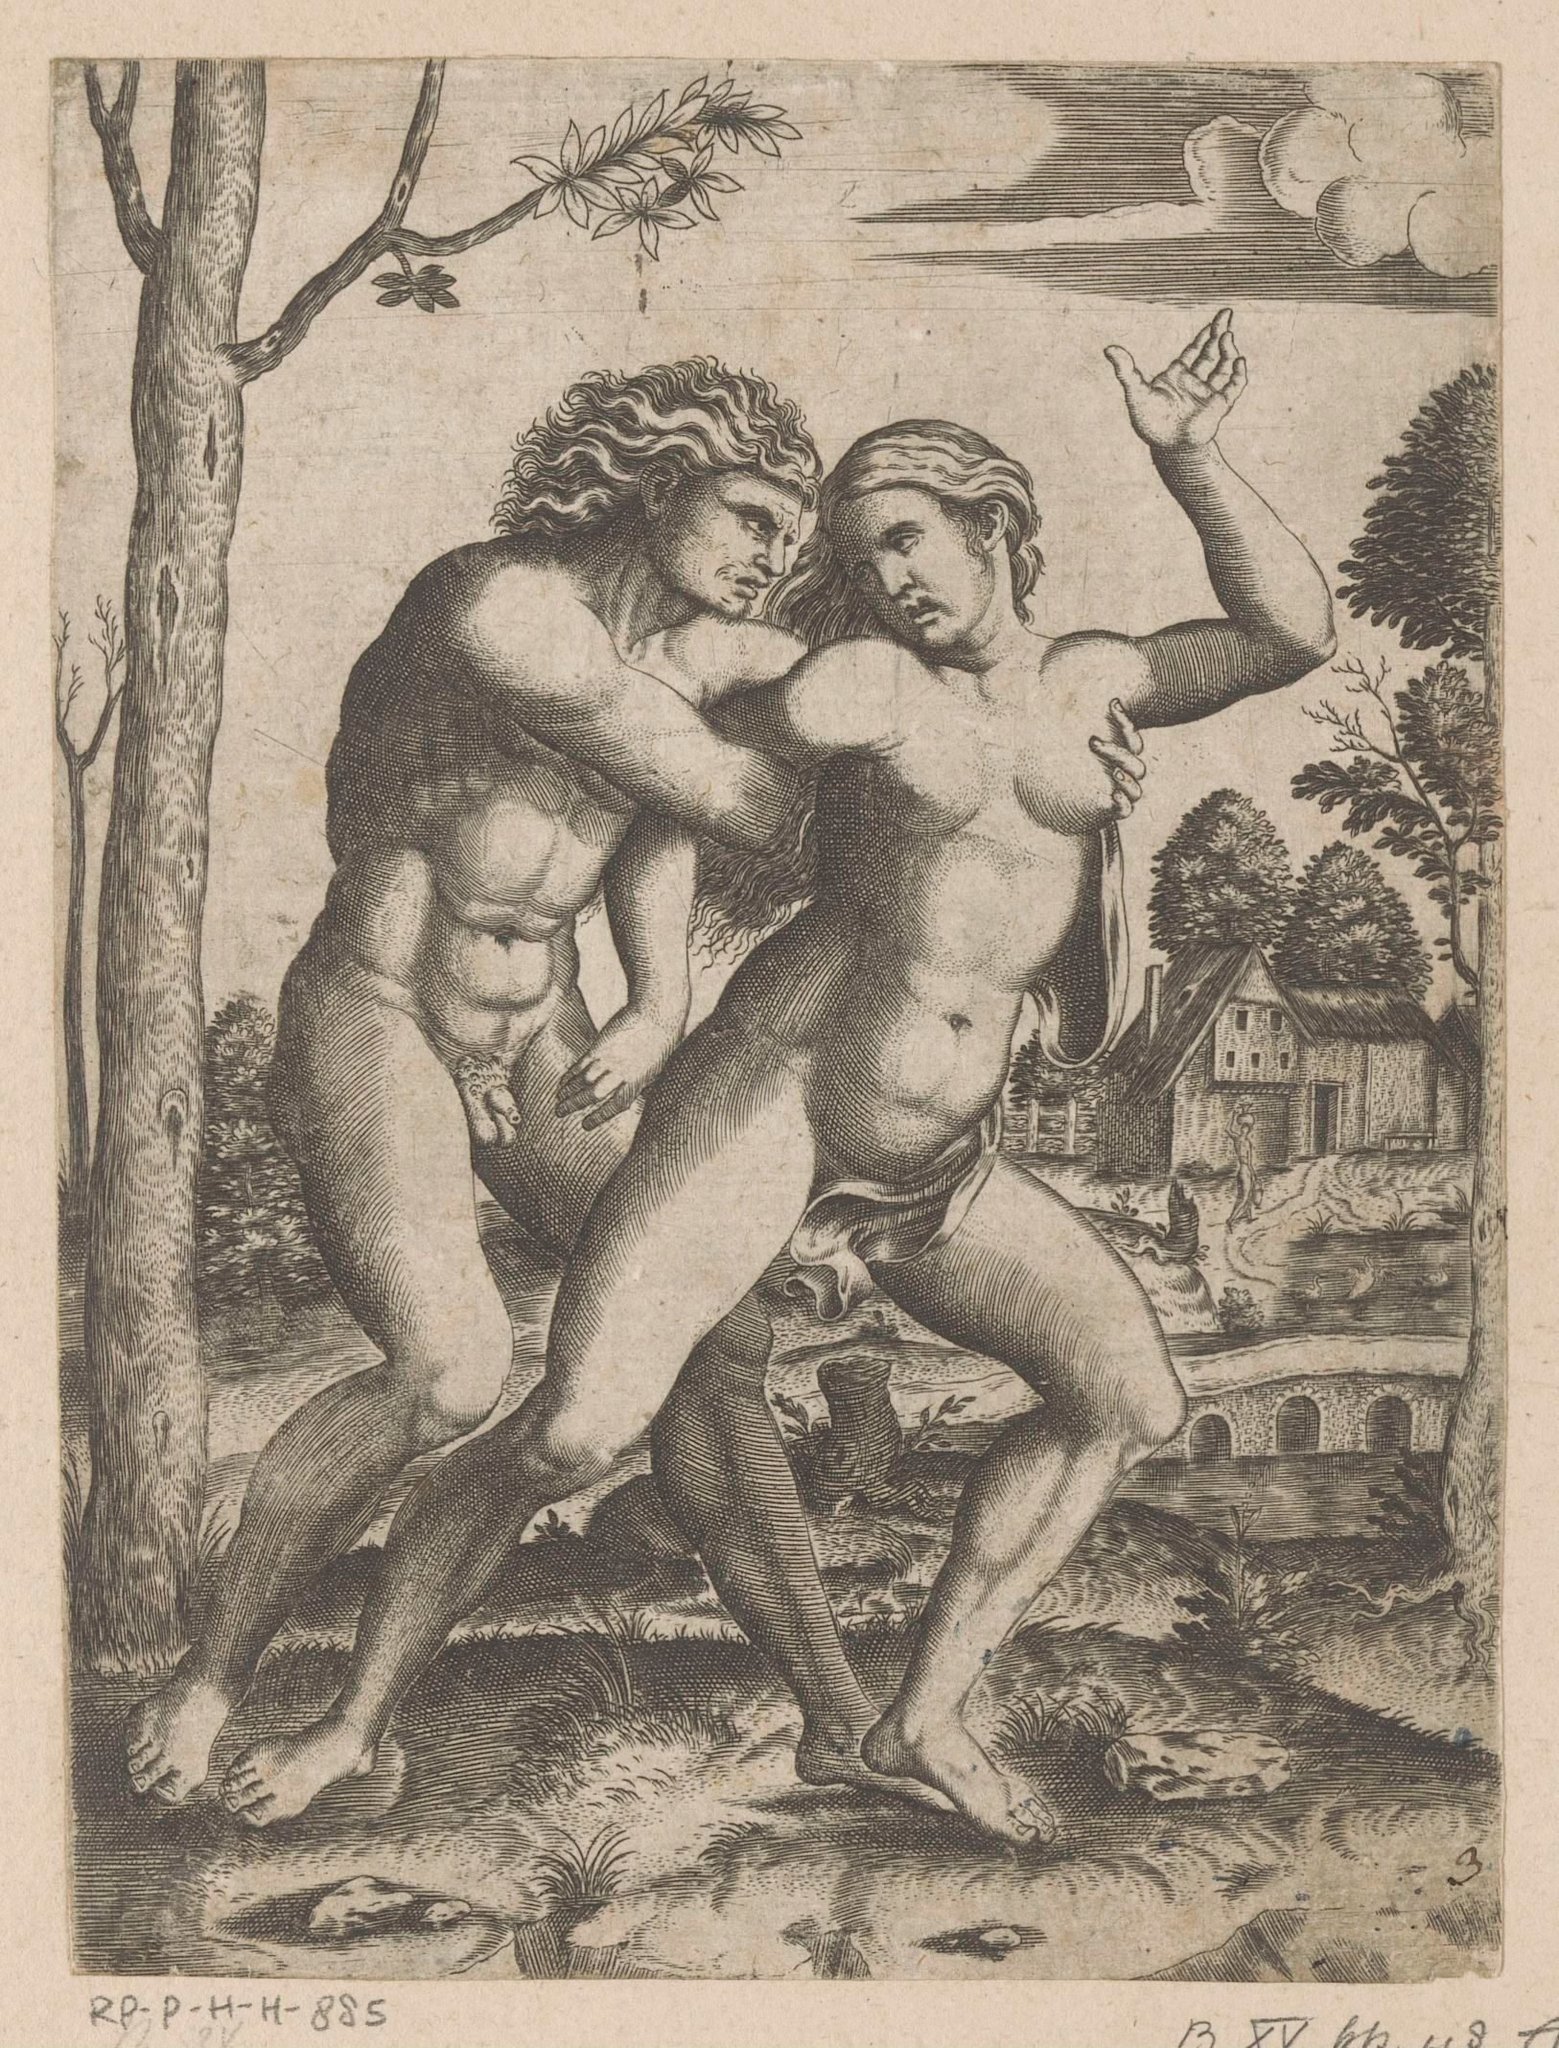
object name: print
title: Vrouw vastgegrepen door een man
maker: Anonymous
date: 1500-1549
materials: paper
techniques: engraving, intaglio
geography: italy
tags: city-view, and landscape with man-made constructions, woman (showing herself) undressed, quasi-nude, flight, running away; pursuing, man (showing himself) undressed, quasi-nude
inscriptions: number: ‘3’, collector's mark: ‘Hinloopen’, collector's mark: Lugt 11, collector's mark: Lugt 10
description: In een landschap wordt een naakte vrouw door een naakte man vastgegrepen, terwijl zij probeert hem te ontvluchten.